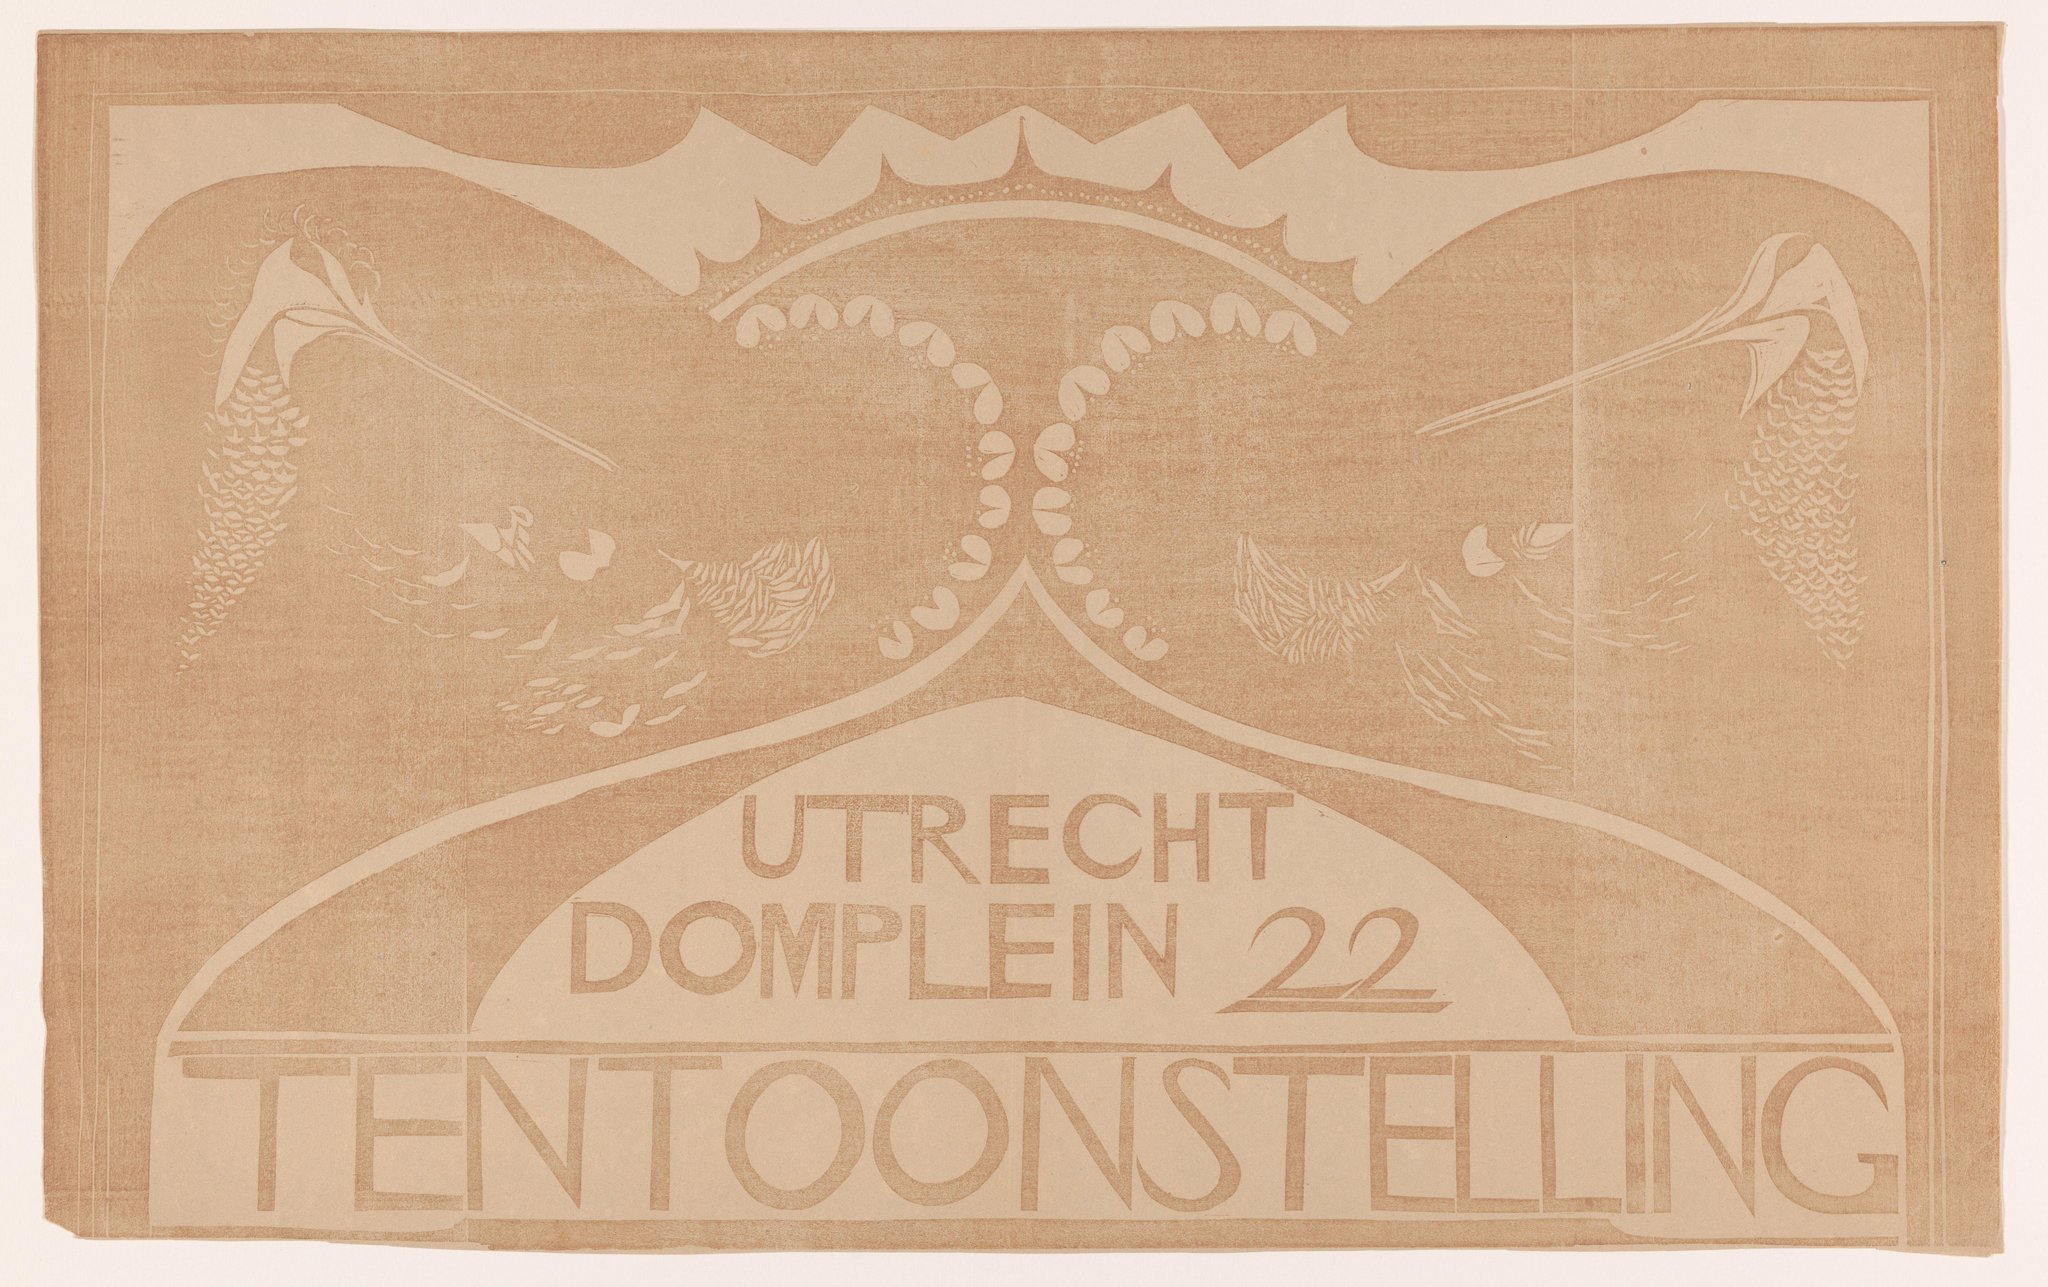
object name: poster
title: Affiche voor een tentoonstelling met twee kolibries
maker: carel adolph lion cachet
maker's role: draughtsman, print maker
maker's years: 1864-1945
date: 1874-1945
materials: paper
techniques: woodcut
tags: other birds (with name), poster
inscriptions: collector's mark: Lugt 2228